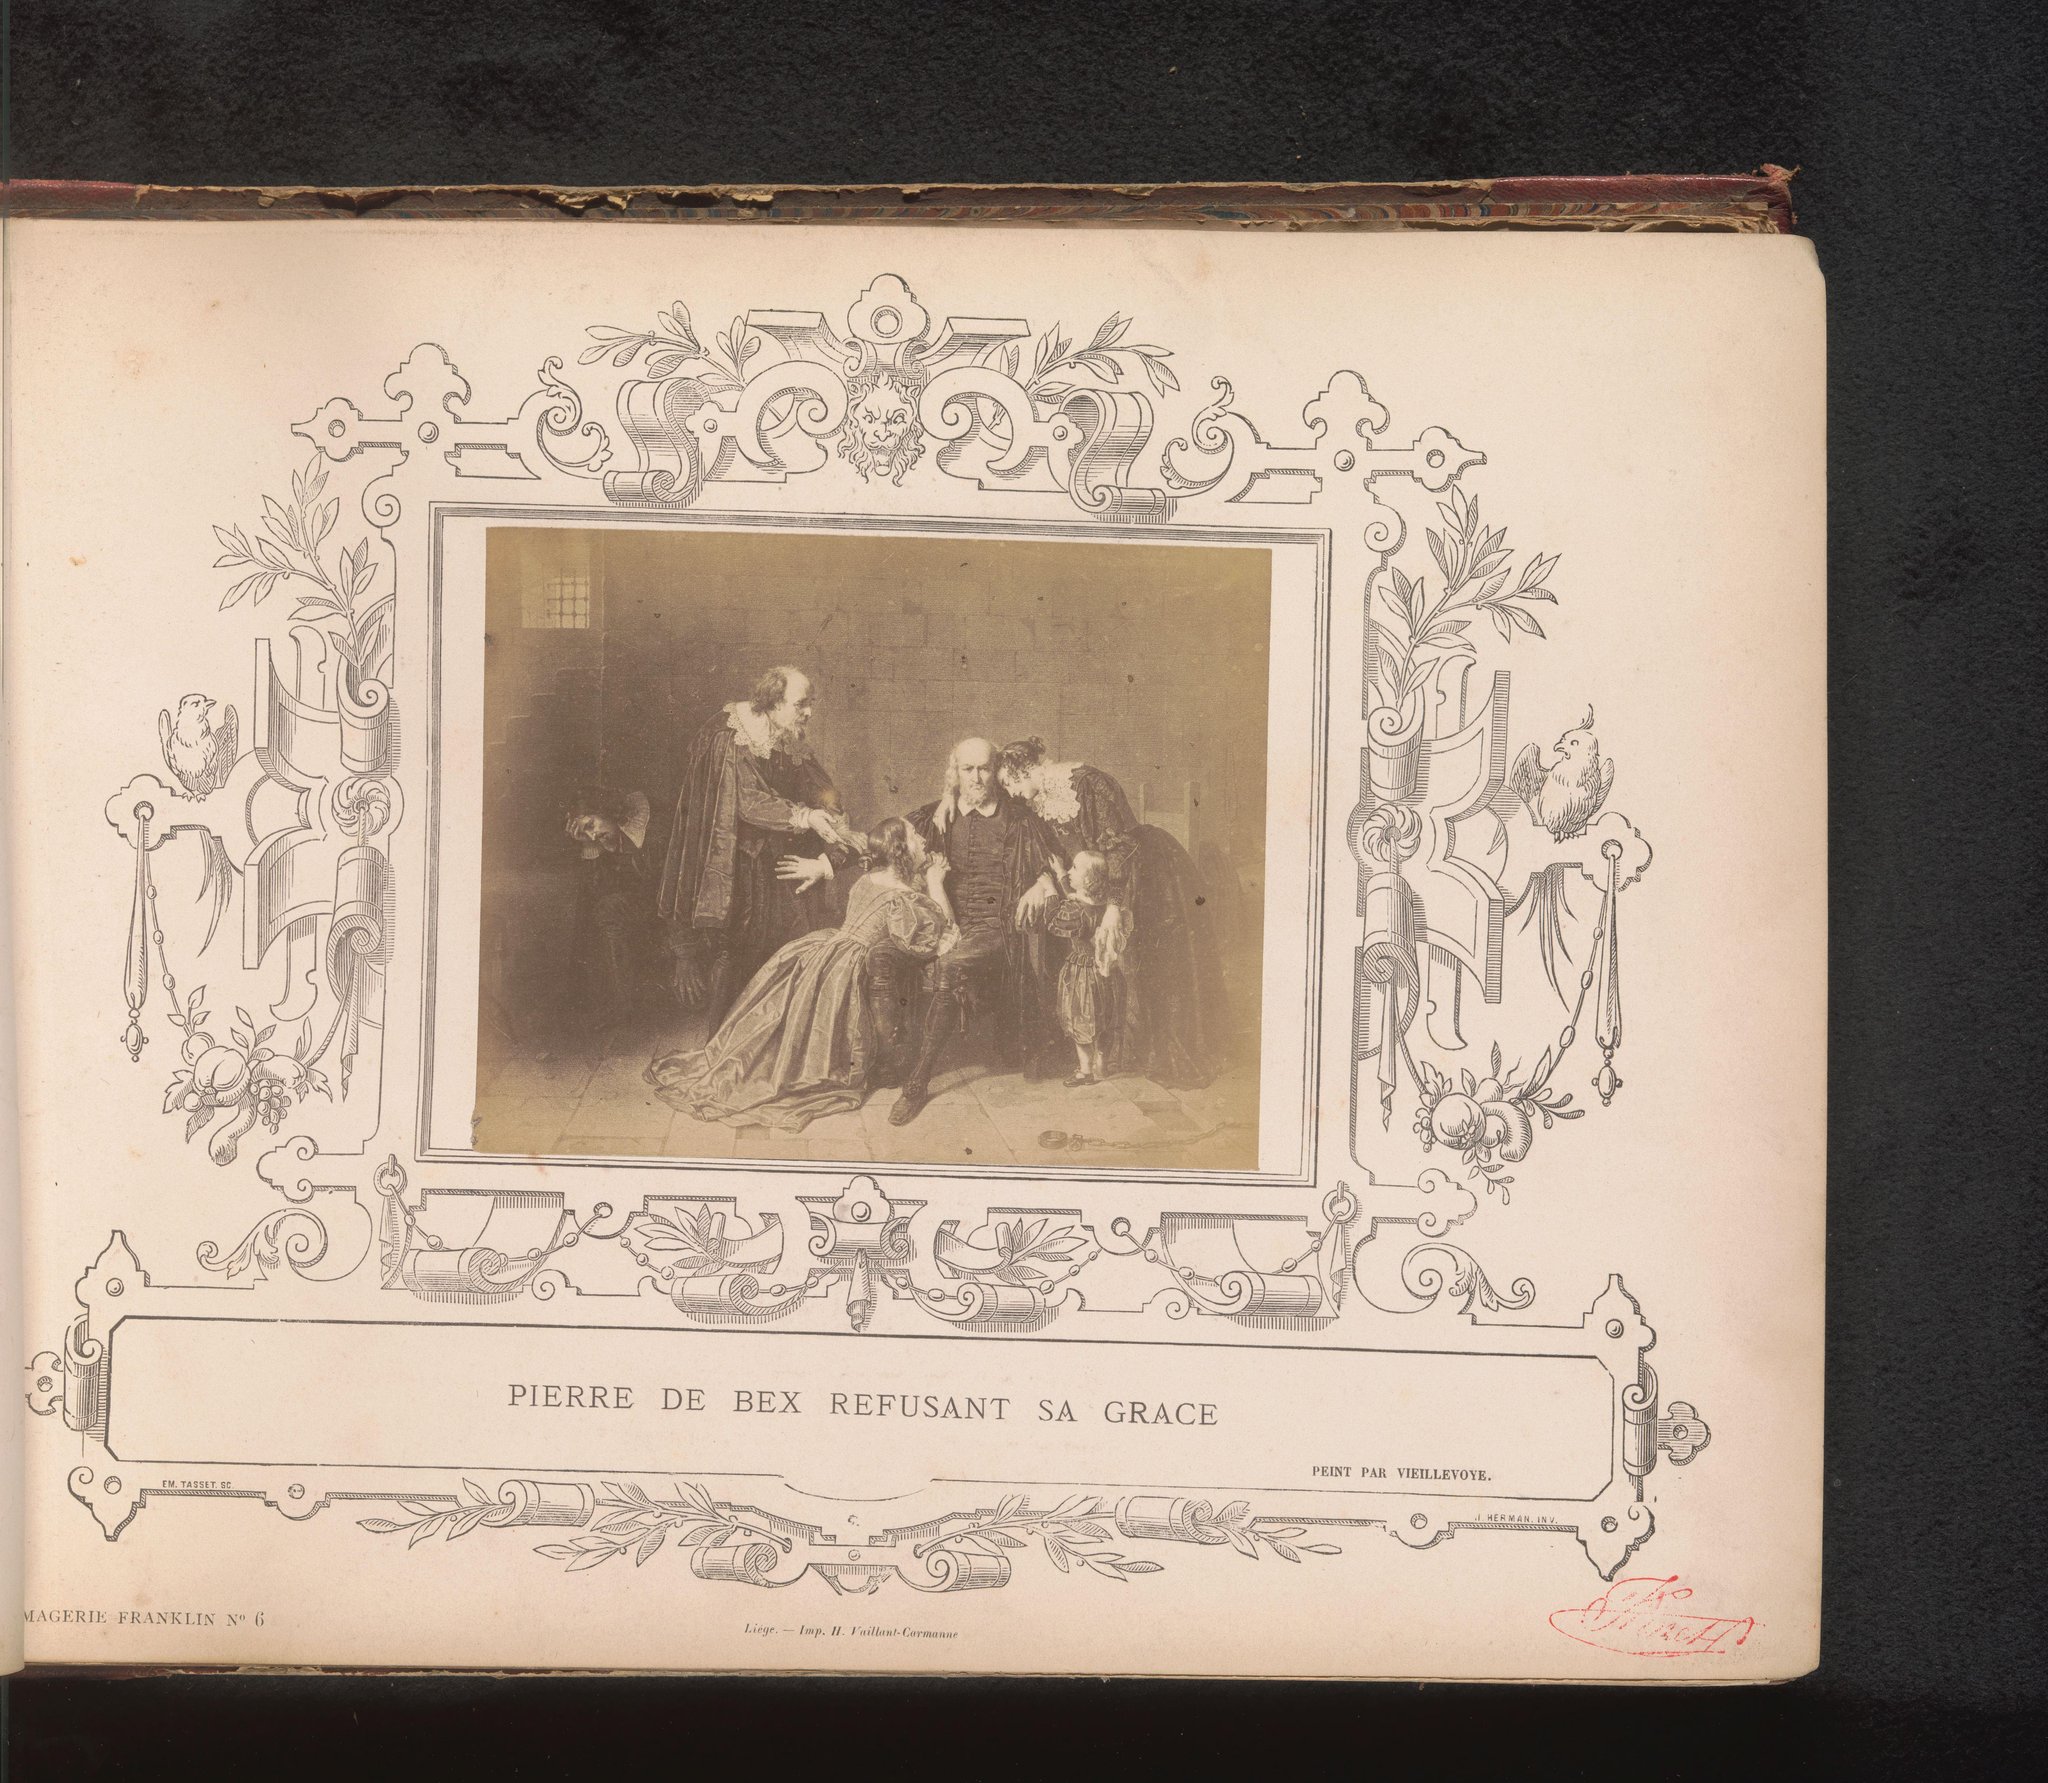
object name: reproduction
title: Fotoreproductie van Pierre de Bex Refusant sa Grace door Joseph Barthélémy Vieillevoye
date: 1871-1880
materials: photographic support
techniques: albumen print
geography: liège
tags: liège, mayor, mayor, burgomaster, last communion, administering of the holy viaticum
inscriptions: inscription: ‘IMAGERIE FRANKLIN No 6.’, signature: ‘K[..]ch’, name: ‘EM. TASSET, SC.’, name: ‘J. HERMAN, INV.’